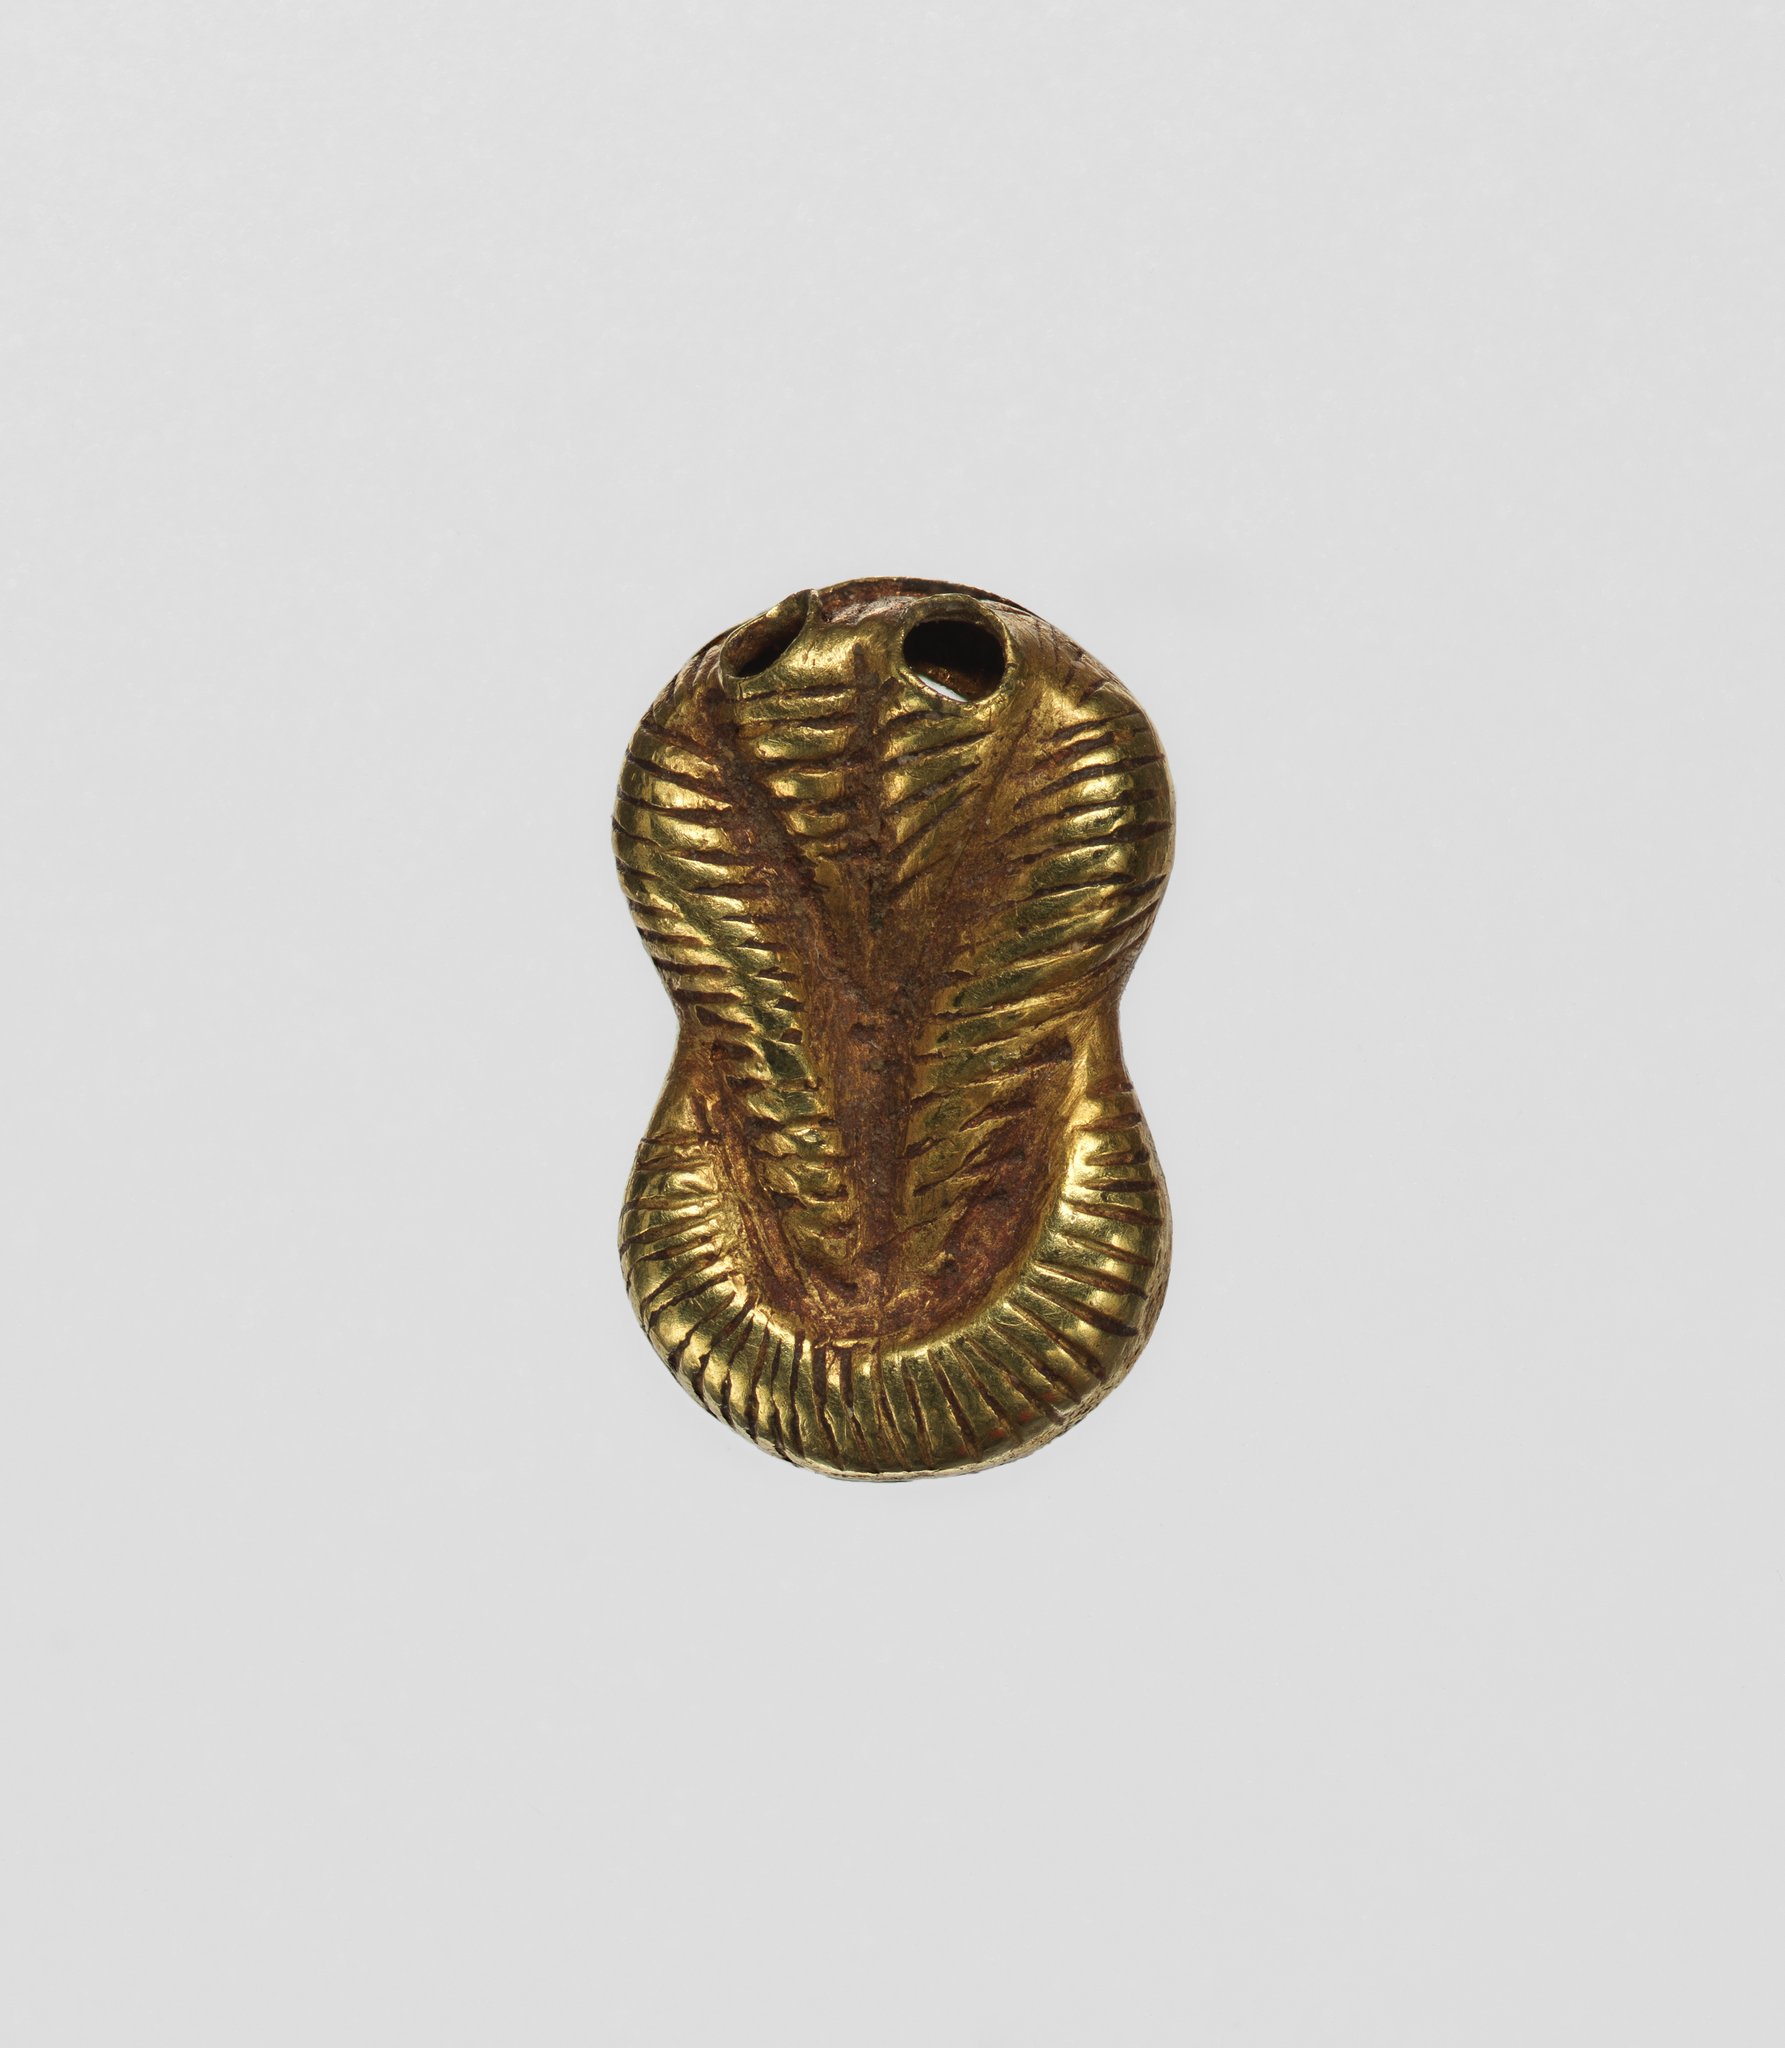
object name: clasp, double knot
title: Half of bracelet clasp: double knot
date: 1991-1540 BCE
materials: gold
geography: memphite region